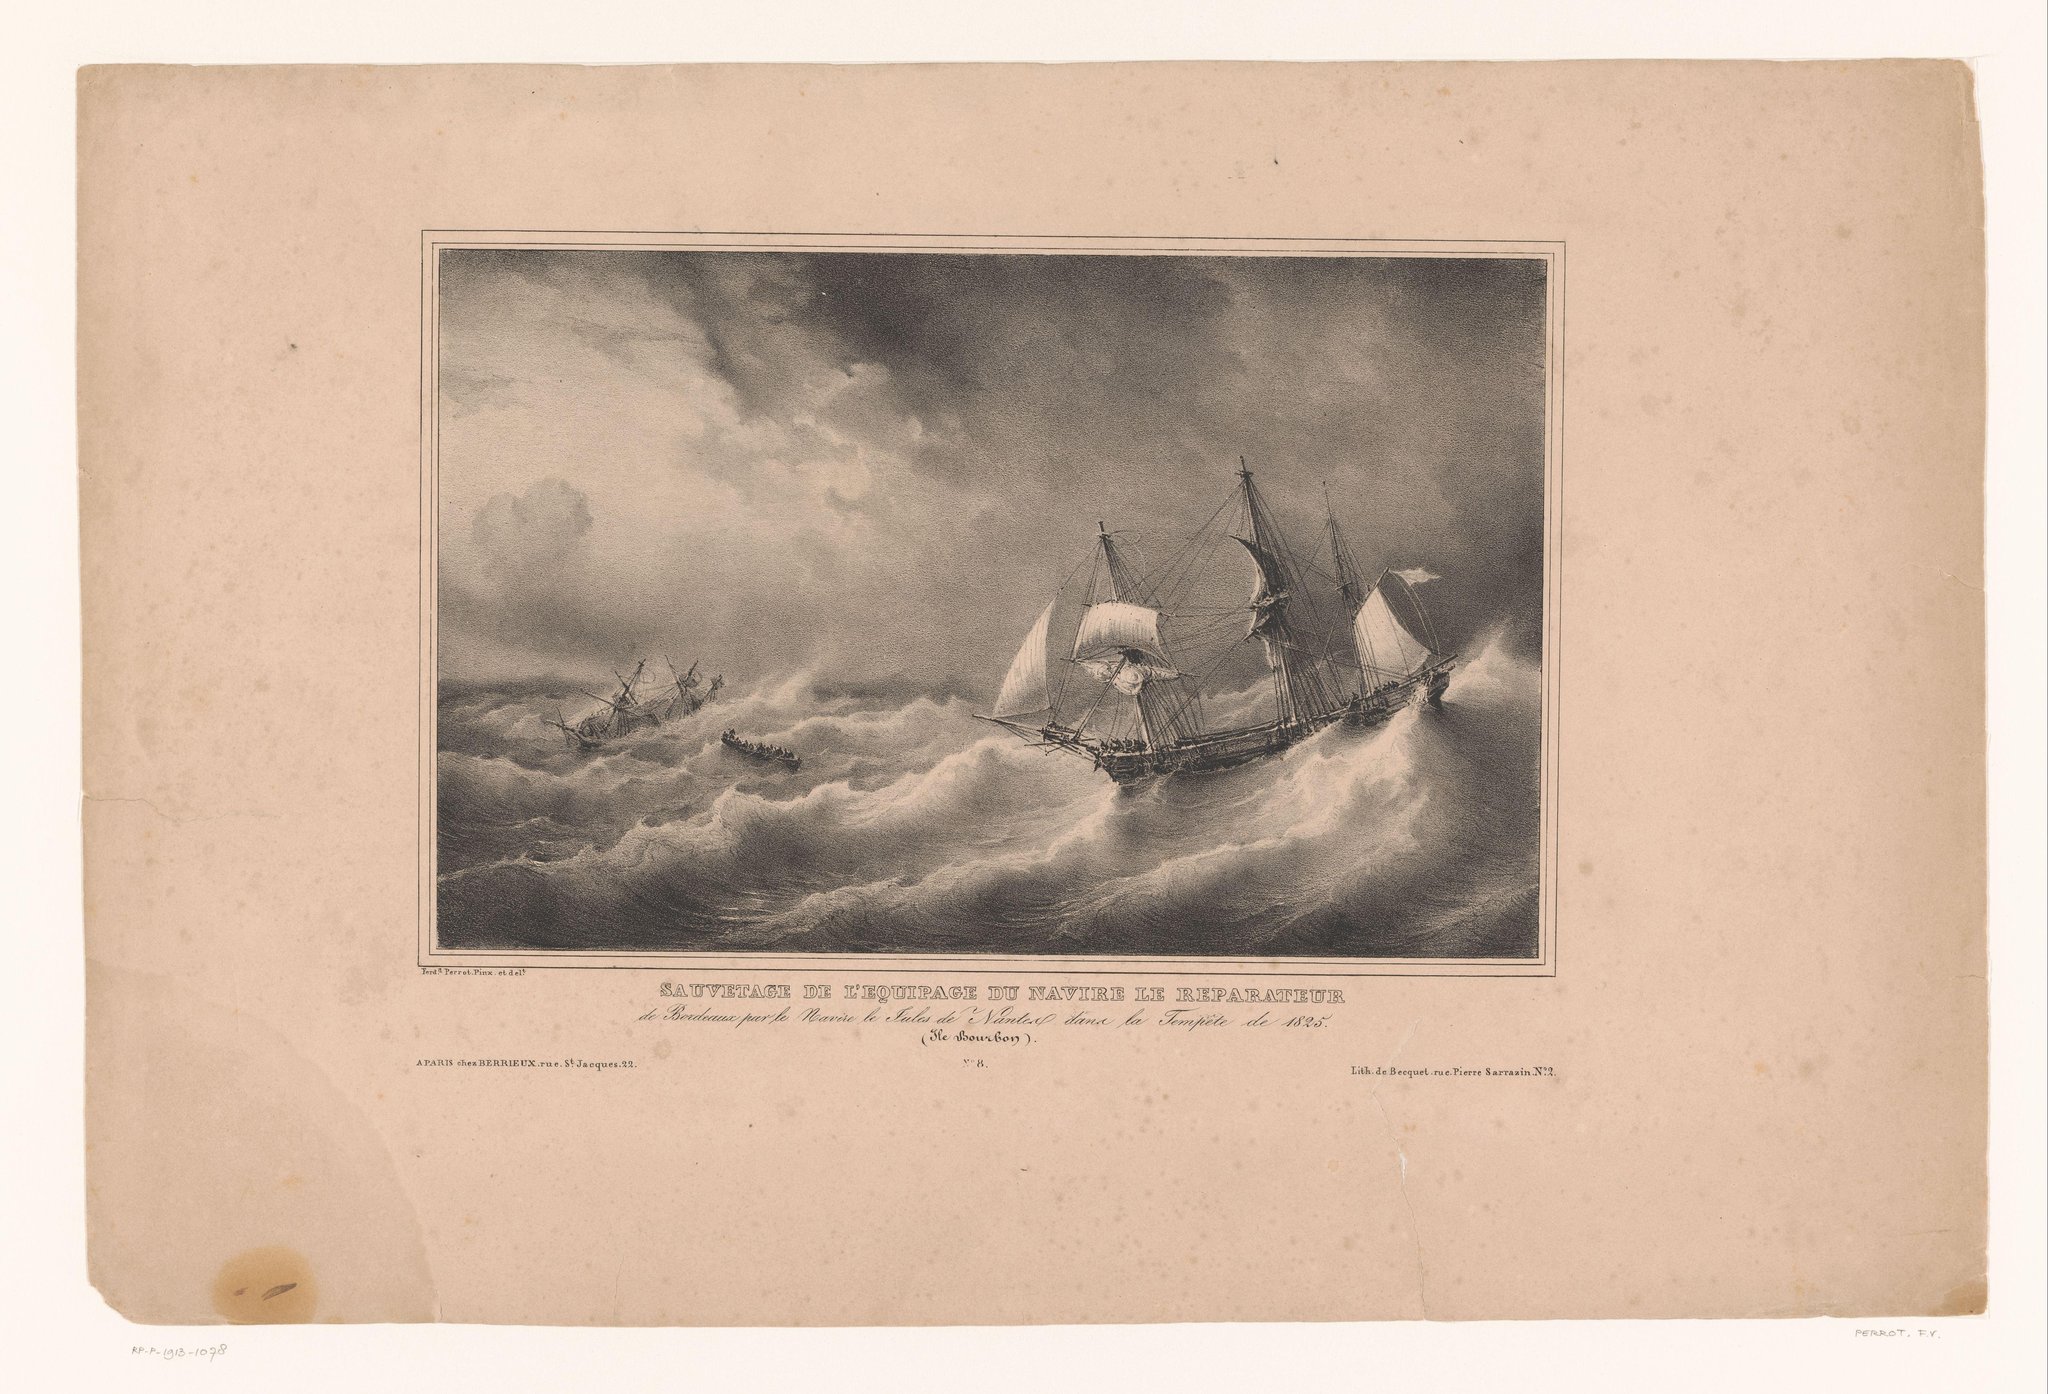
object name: print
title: Redding van de bemanning van het schip de Reparateur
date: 1832-1843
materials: paper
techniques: lithograph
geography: paris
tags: shipwreck, storm at sea, sea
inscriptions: collector's mark: Lugt 2228